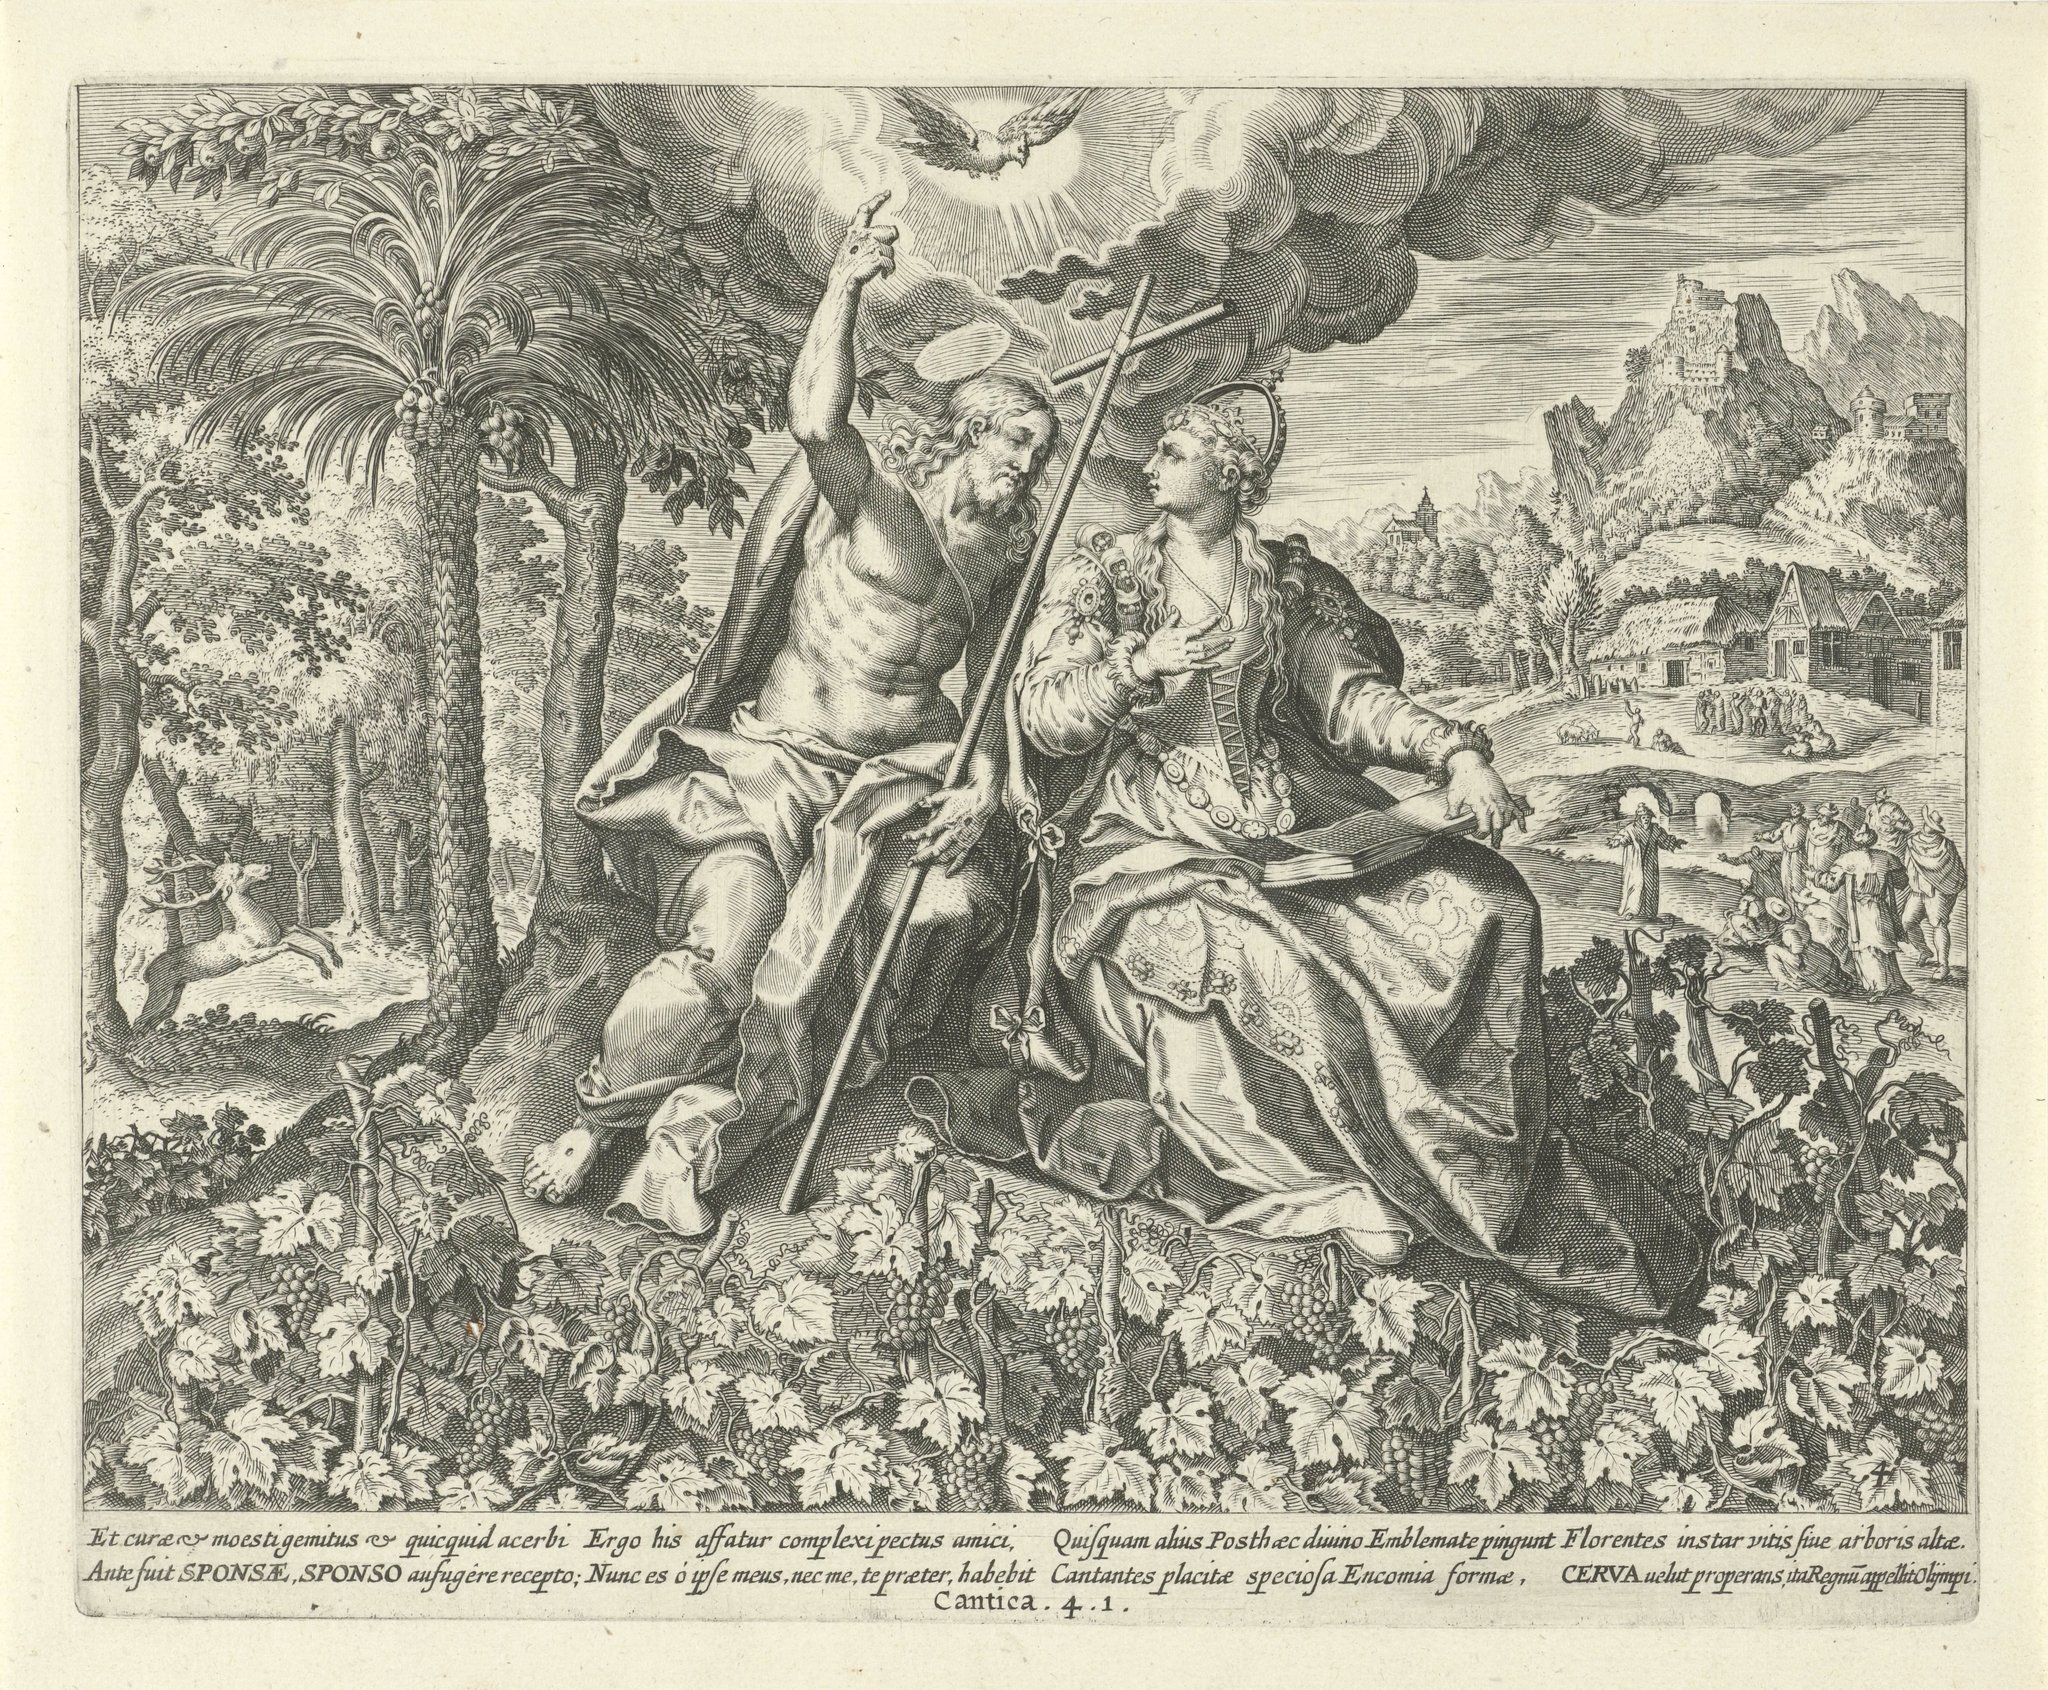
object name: print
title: Cantica. 4.1.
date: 1590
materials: paper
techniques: engraving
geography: antwerp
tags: vine, 'ecclesia' as bride of christ (the lamb), 'ecclesia sponsa dei', 'sponsus-sponsa', song of solomon, song of songs (with book chapter:verse) (+ holy ghost (song of sol. 4:1)), song of solomon, song of songs (with book chapter:verse) (+ christ bearded), garden, hoofed animals: stag, preaching (in general)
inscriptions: collector's mark: Lugt 2228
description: Christus en zijn bruid, zittend in een landschap met wijnranken op de voorgrond. Christus wijst naar boven waar de Heilige Geest in de gedaante van een duif te zien is. Linksachter dadelpalmen en een hert. Rechts op de achtergrond luistert een menigte naar een preek. De prent heeft een Latijns onderschrift over het hooglied van Salomo.